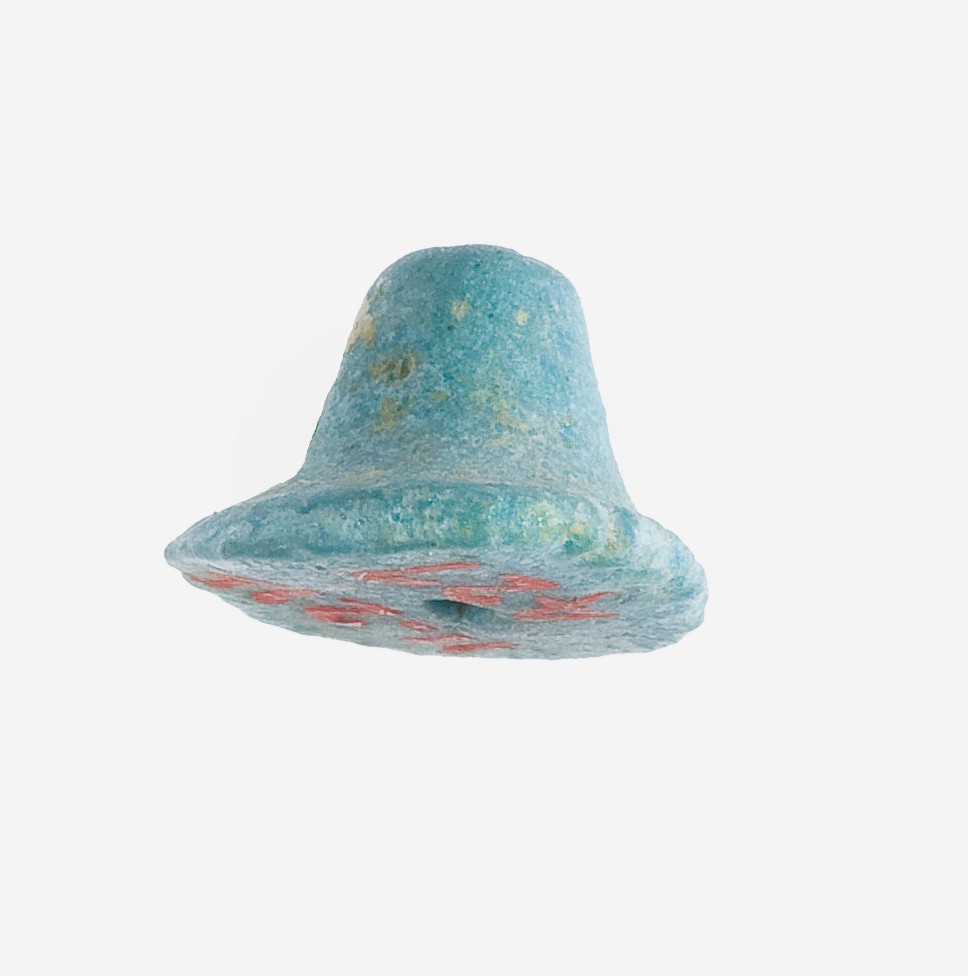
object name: pendant, umbel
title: Umbel Pendant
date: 1390-1352 BCE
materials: faience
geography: egypt